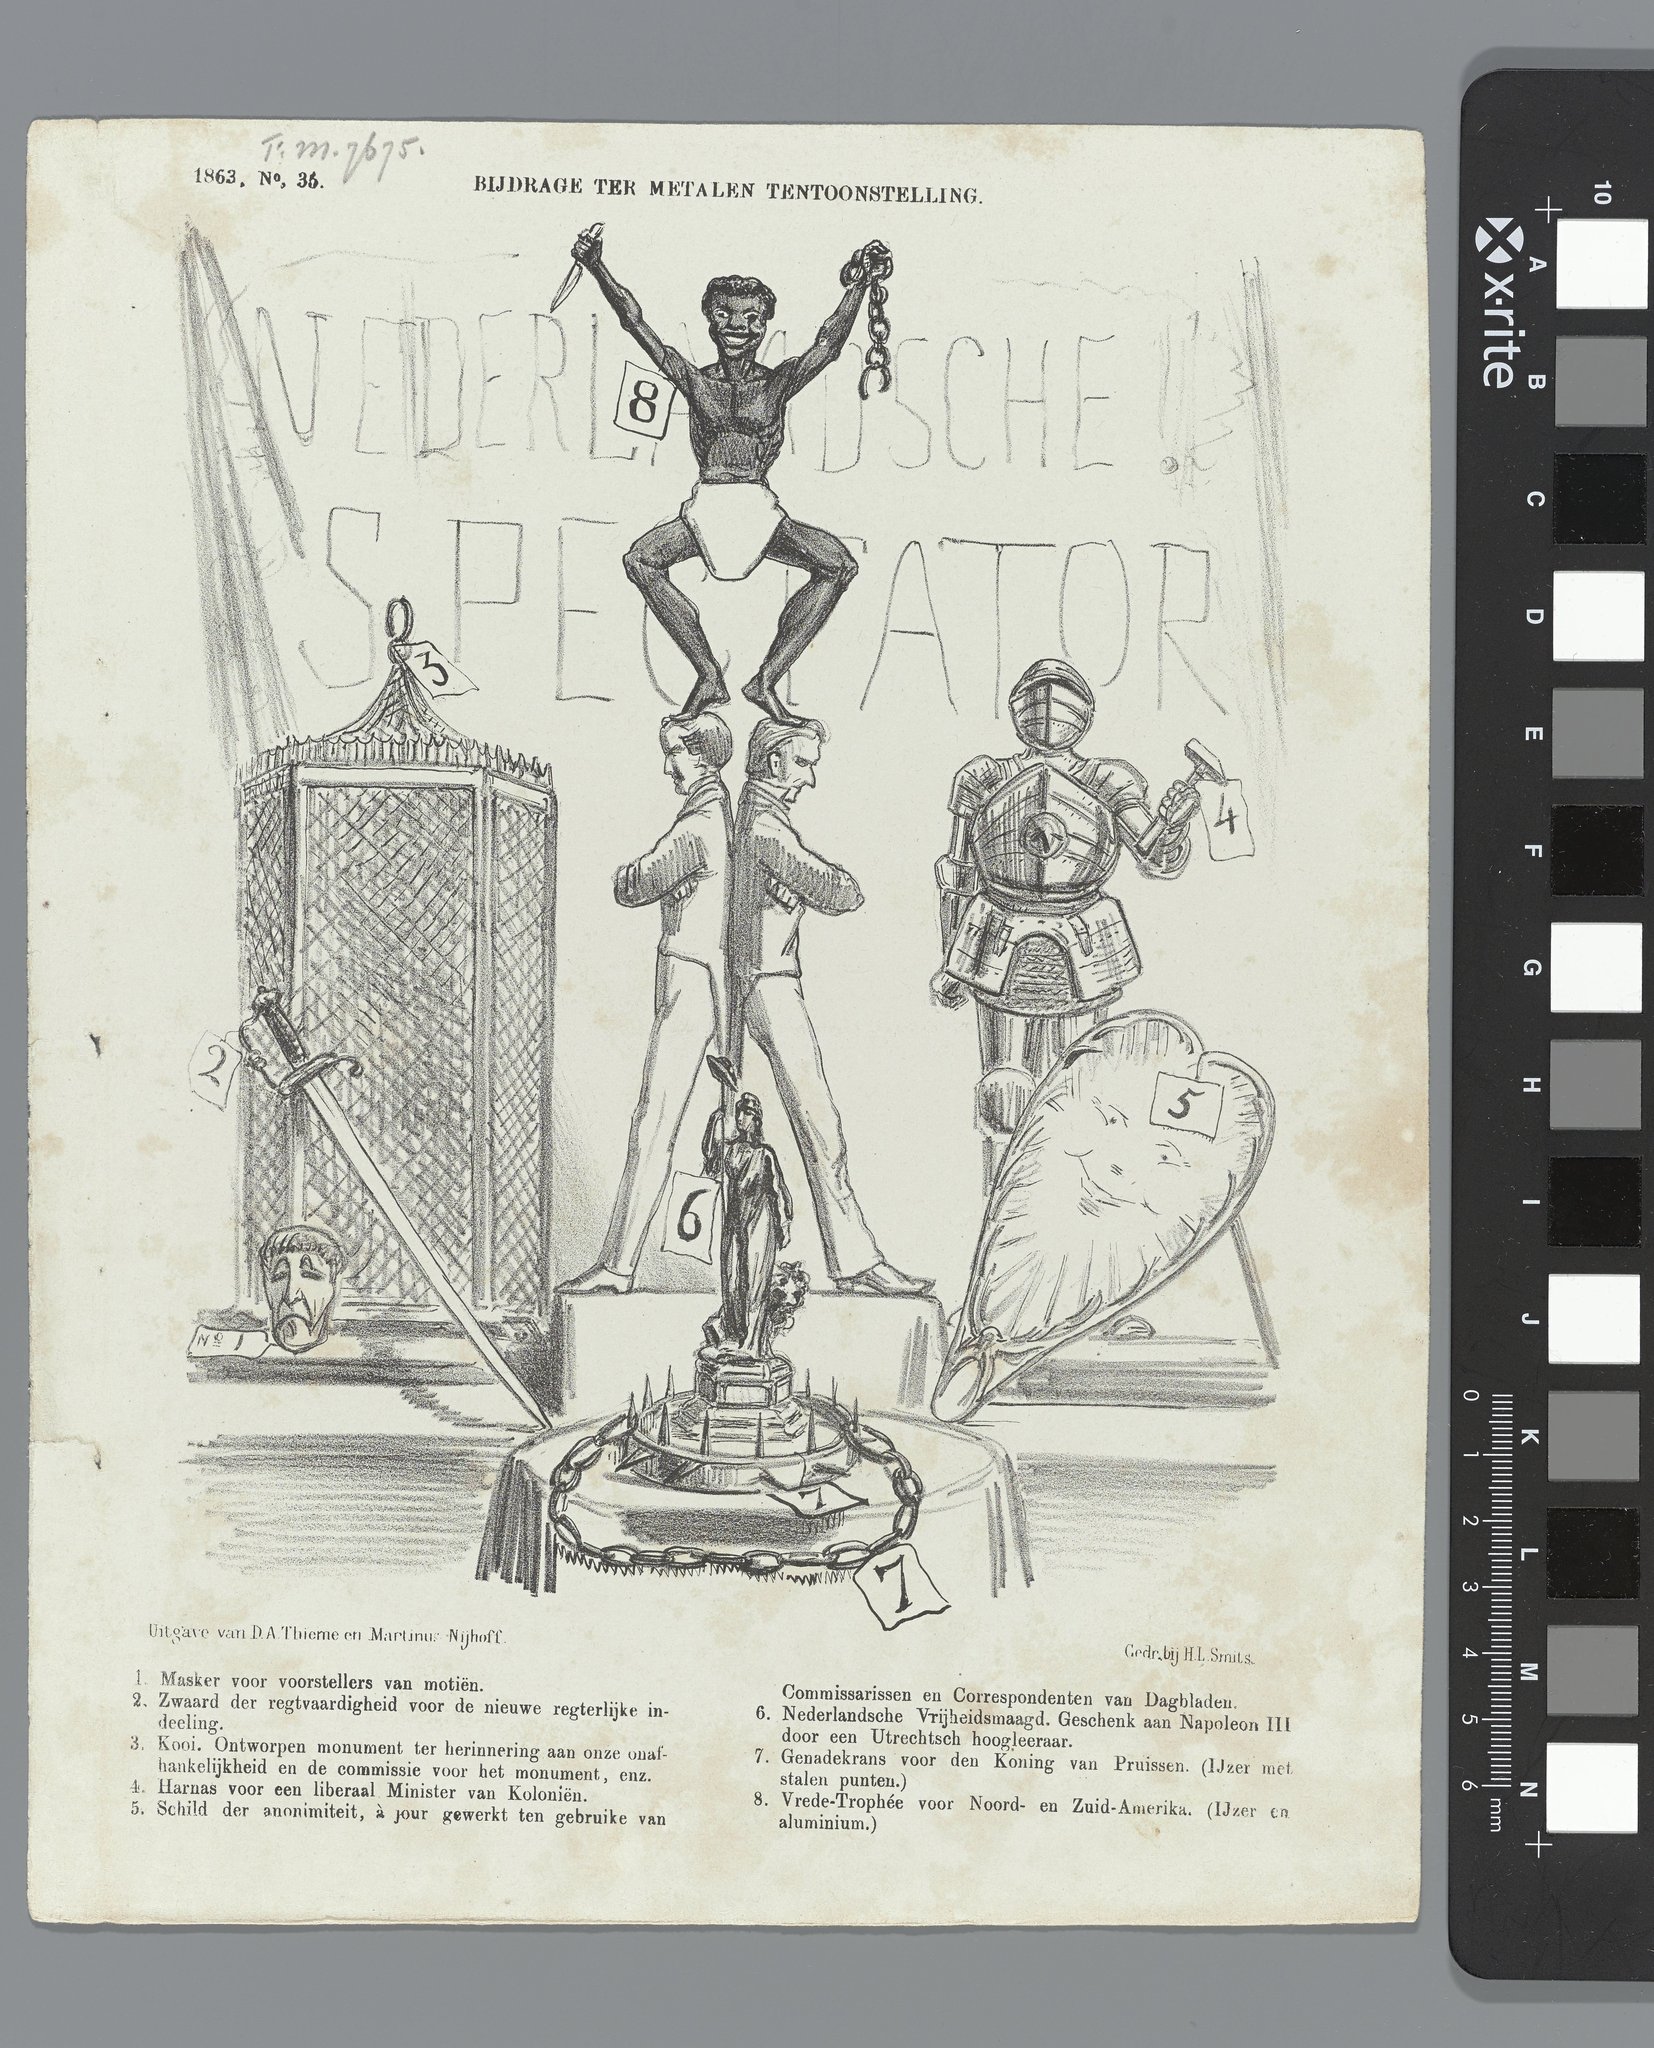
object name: cartoon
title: Spotprent met allerlei metalen voorwerpen, 1863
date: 1863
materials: paper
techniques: lithograph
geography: the hague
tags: abolition of slavery, fighting slavery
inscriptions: collector's mark: Lugt 2228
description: Spotprent met een tentoonstelling van allerlei symbolische metalen voorwerpen vervaardigd in betrekking tot verschillende binnenlandse en buitenlandse politieke gebeurtenissen. Bijvoorbeeld een juichende voormalige tot slaaf gemaakte man van Afrikaanse oorsprong als 'Vrede-Trophée voor Noord- en Zuid-Amerika'. Plaat verschenen bij het weekblad De Nederlandsche Spectator, nr. 35, 29 augustus 1863.